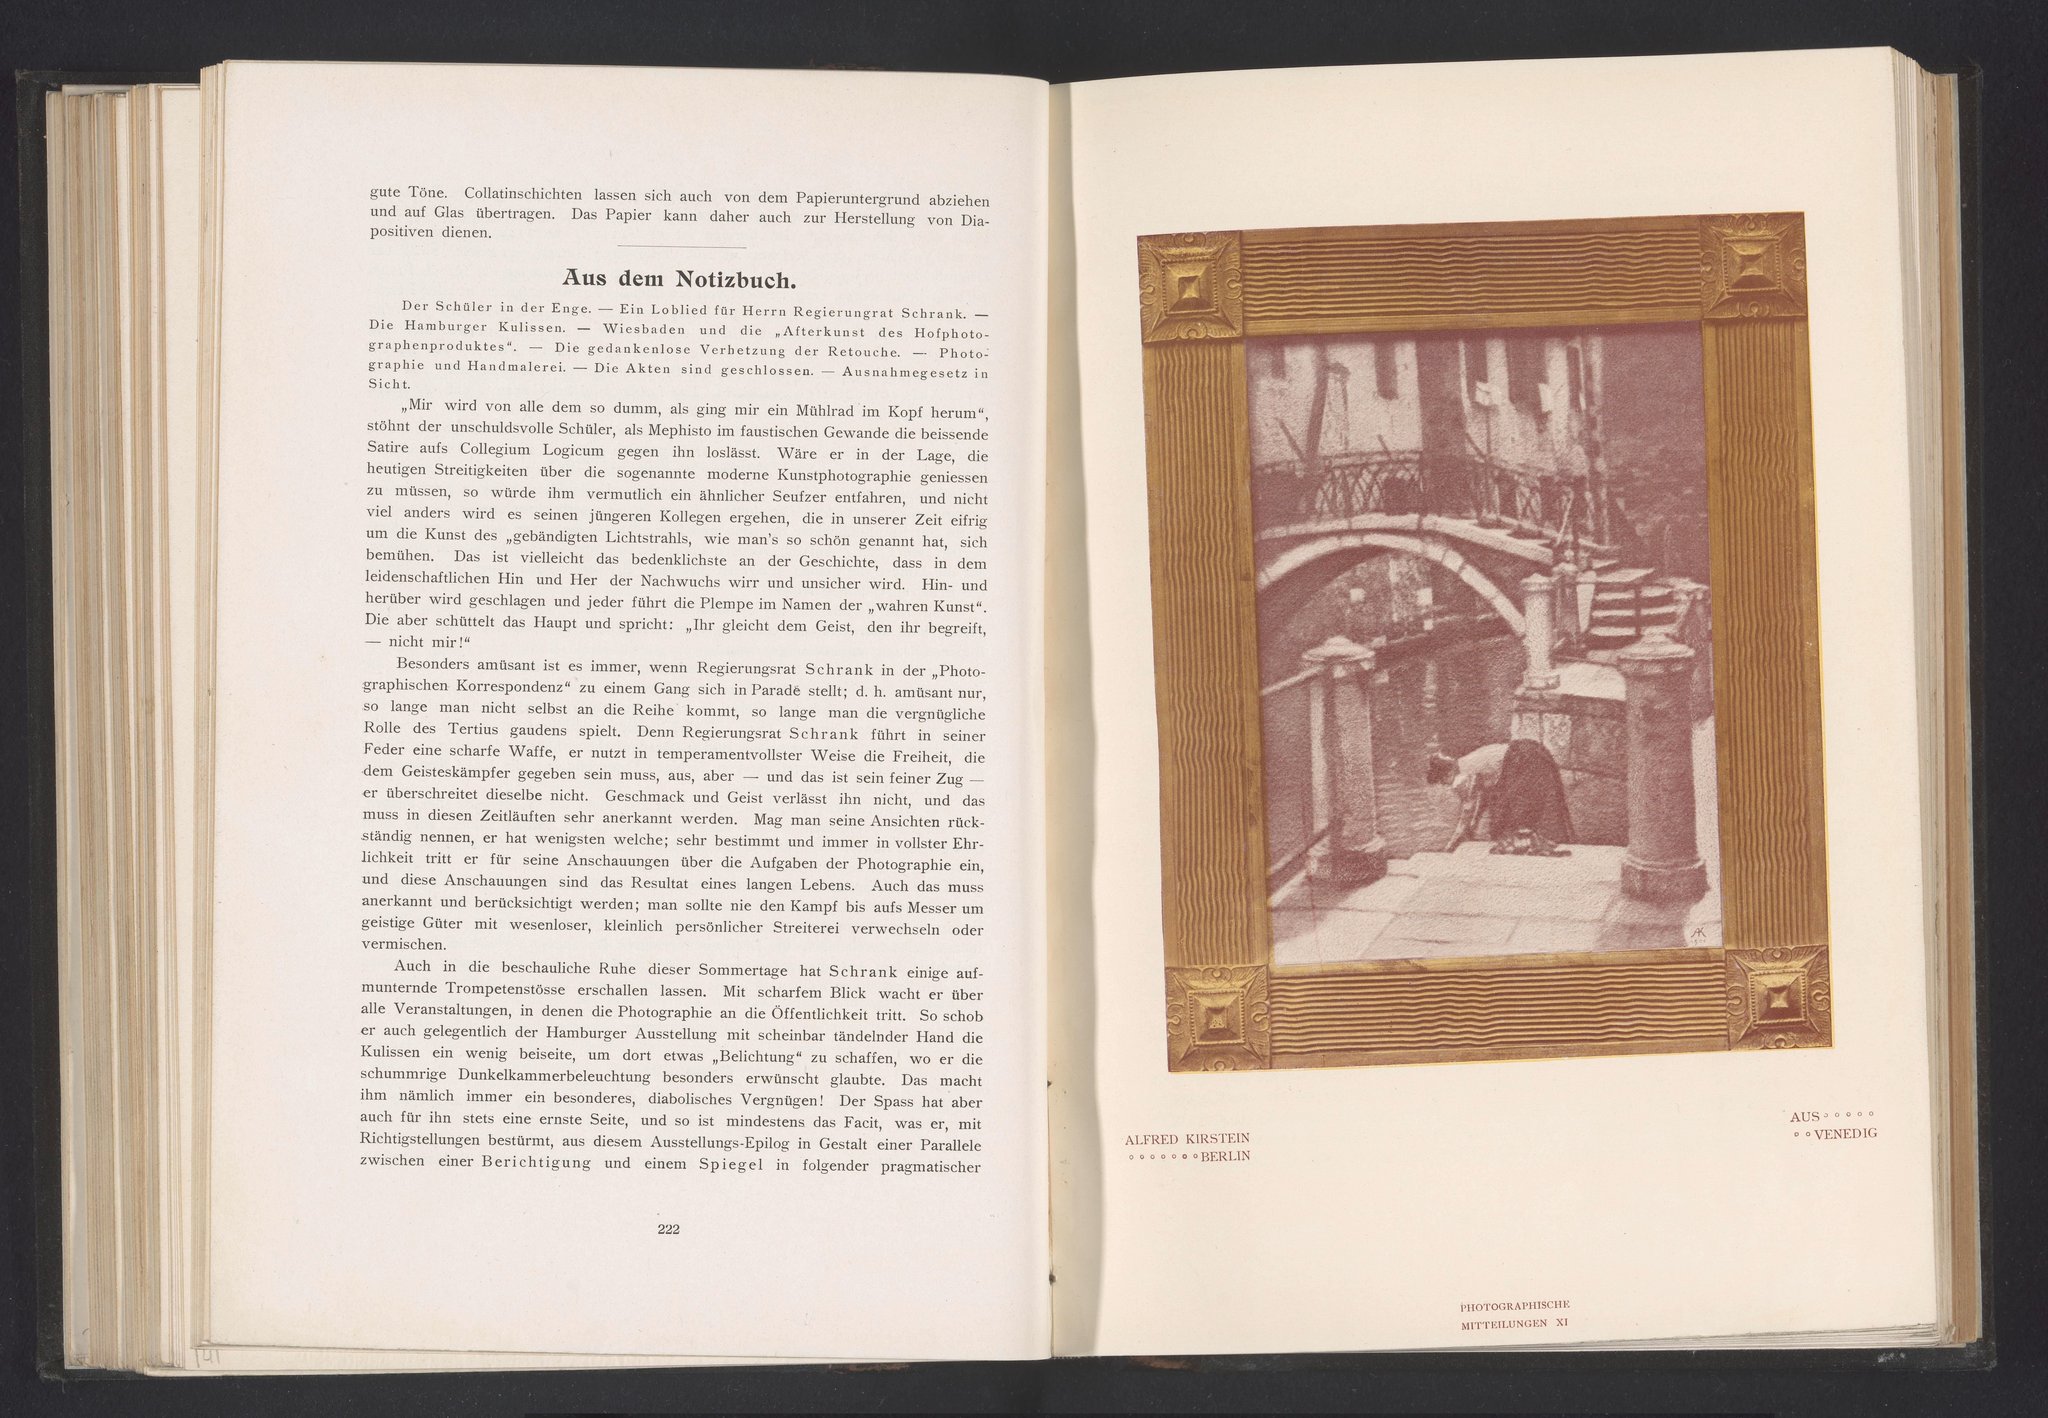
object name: photomechanical print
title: Gezicht op een brug en kanaal in Venetië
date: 1898-1903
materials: paper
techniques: two-color autotype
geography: venice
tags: canal, bridge in city across river, canal, etc., venice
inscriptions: inscription: ‘Photographische Mitteilungen XL’